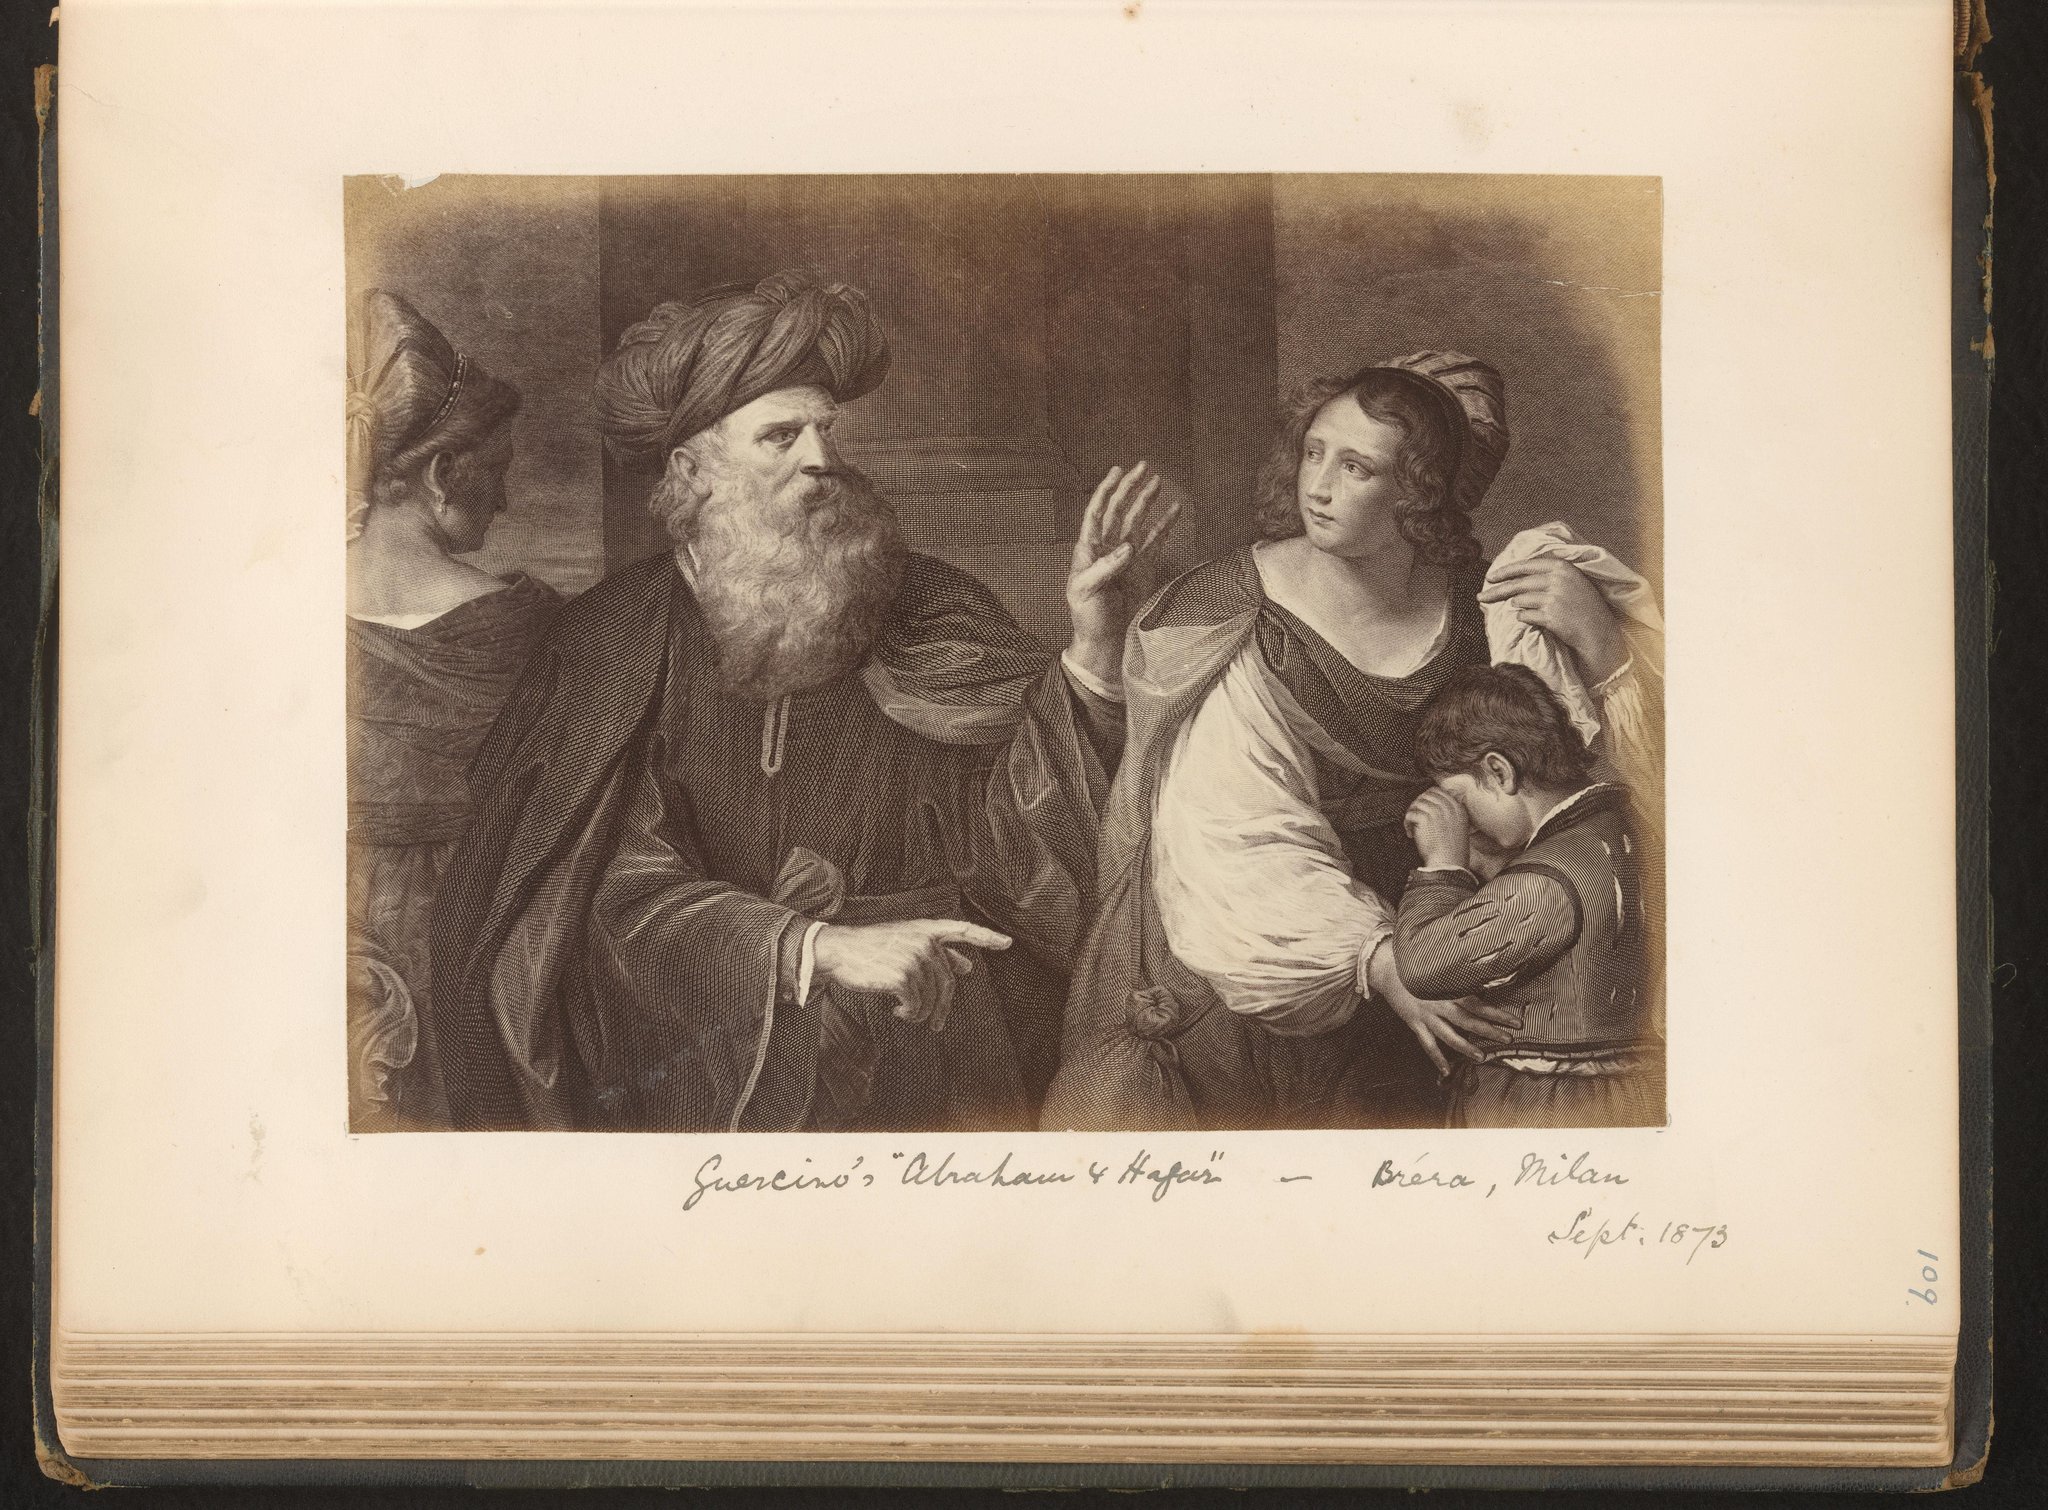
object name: photograph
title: Fotoreproductie van een prent van of naar Guercino's Abramo ripudia Agar e Ismaele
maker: Anonymous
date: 1809-1873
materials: paper, photographic support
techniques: albumen print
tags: the graphic arts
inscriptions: annotation: ‘Guernico's "Abraham [...]’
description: Deze pagina maakt deel uit van een album.